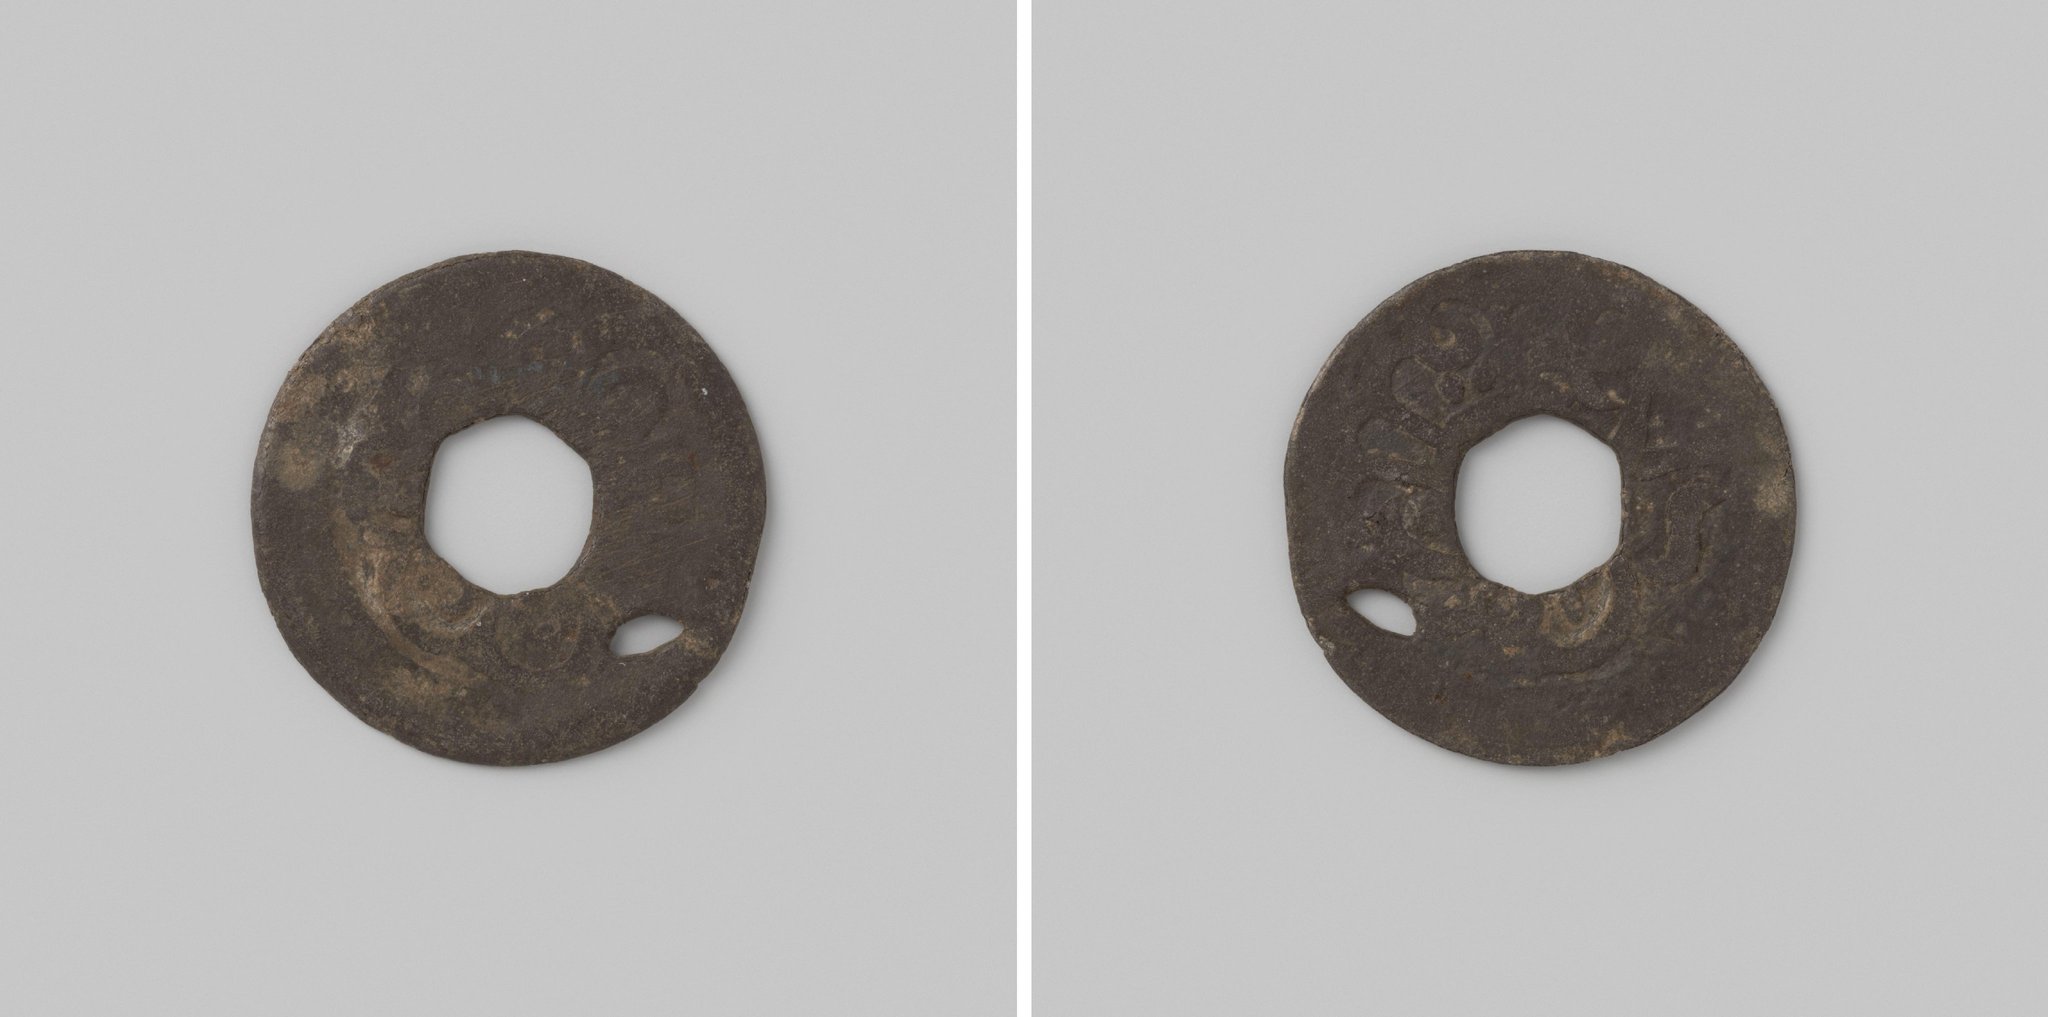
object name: coin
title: Pitji van het Sultanaat Kedah, deel van Thailand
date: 1821-1900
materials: tin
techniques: casting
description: Tinnen munt. Voorzijde:bloemachtige figuratie. Keerzijde: niet nader te determineren omschrift in Arabische lettertekens. In het midden zeshoekig gat.